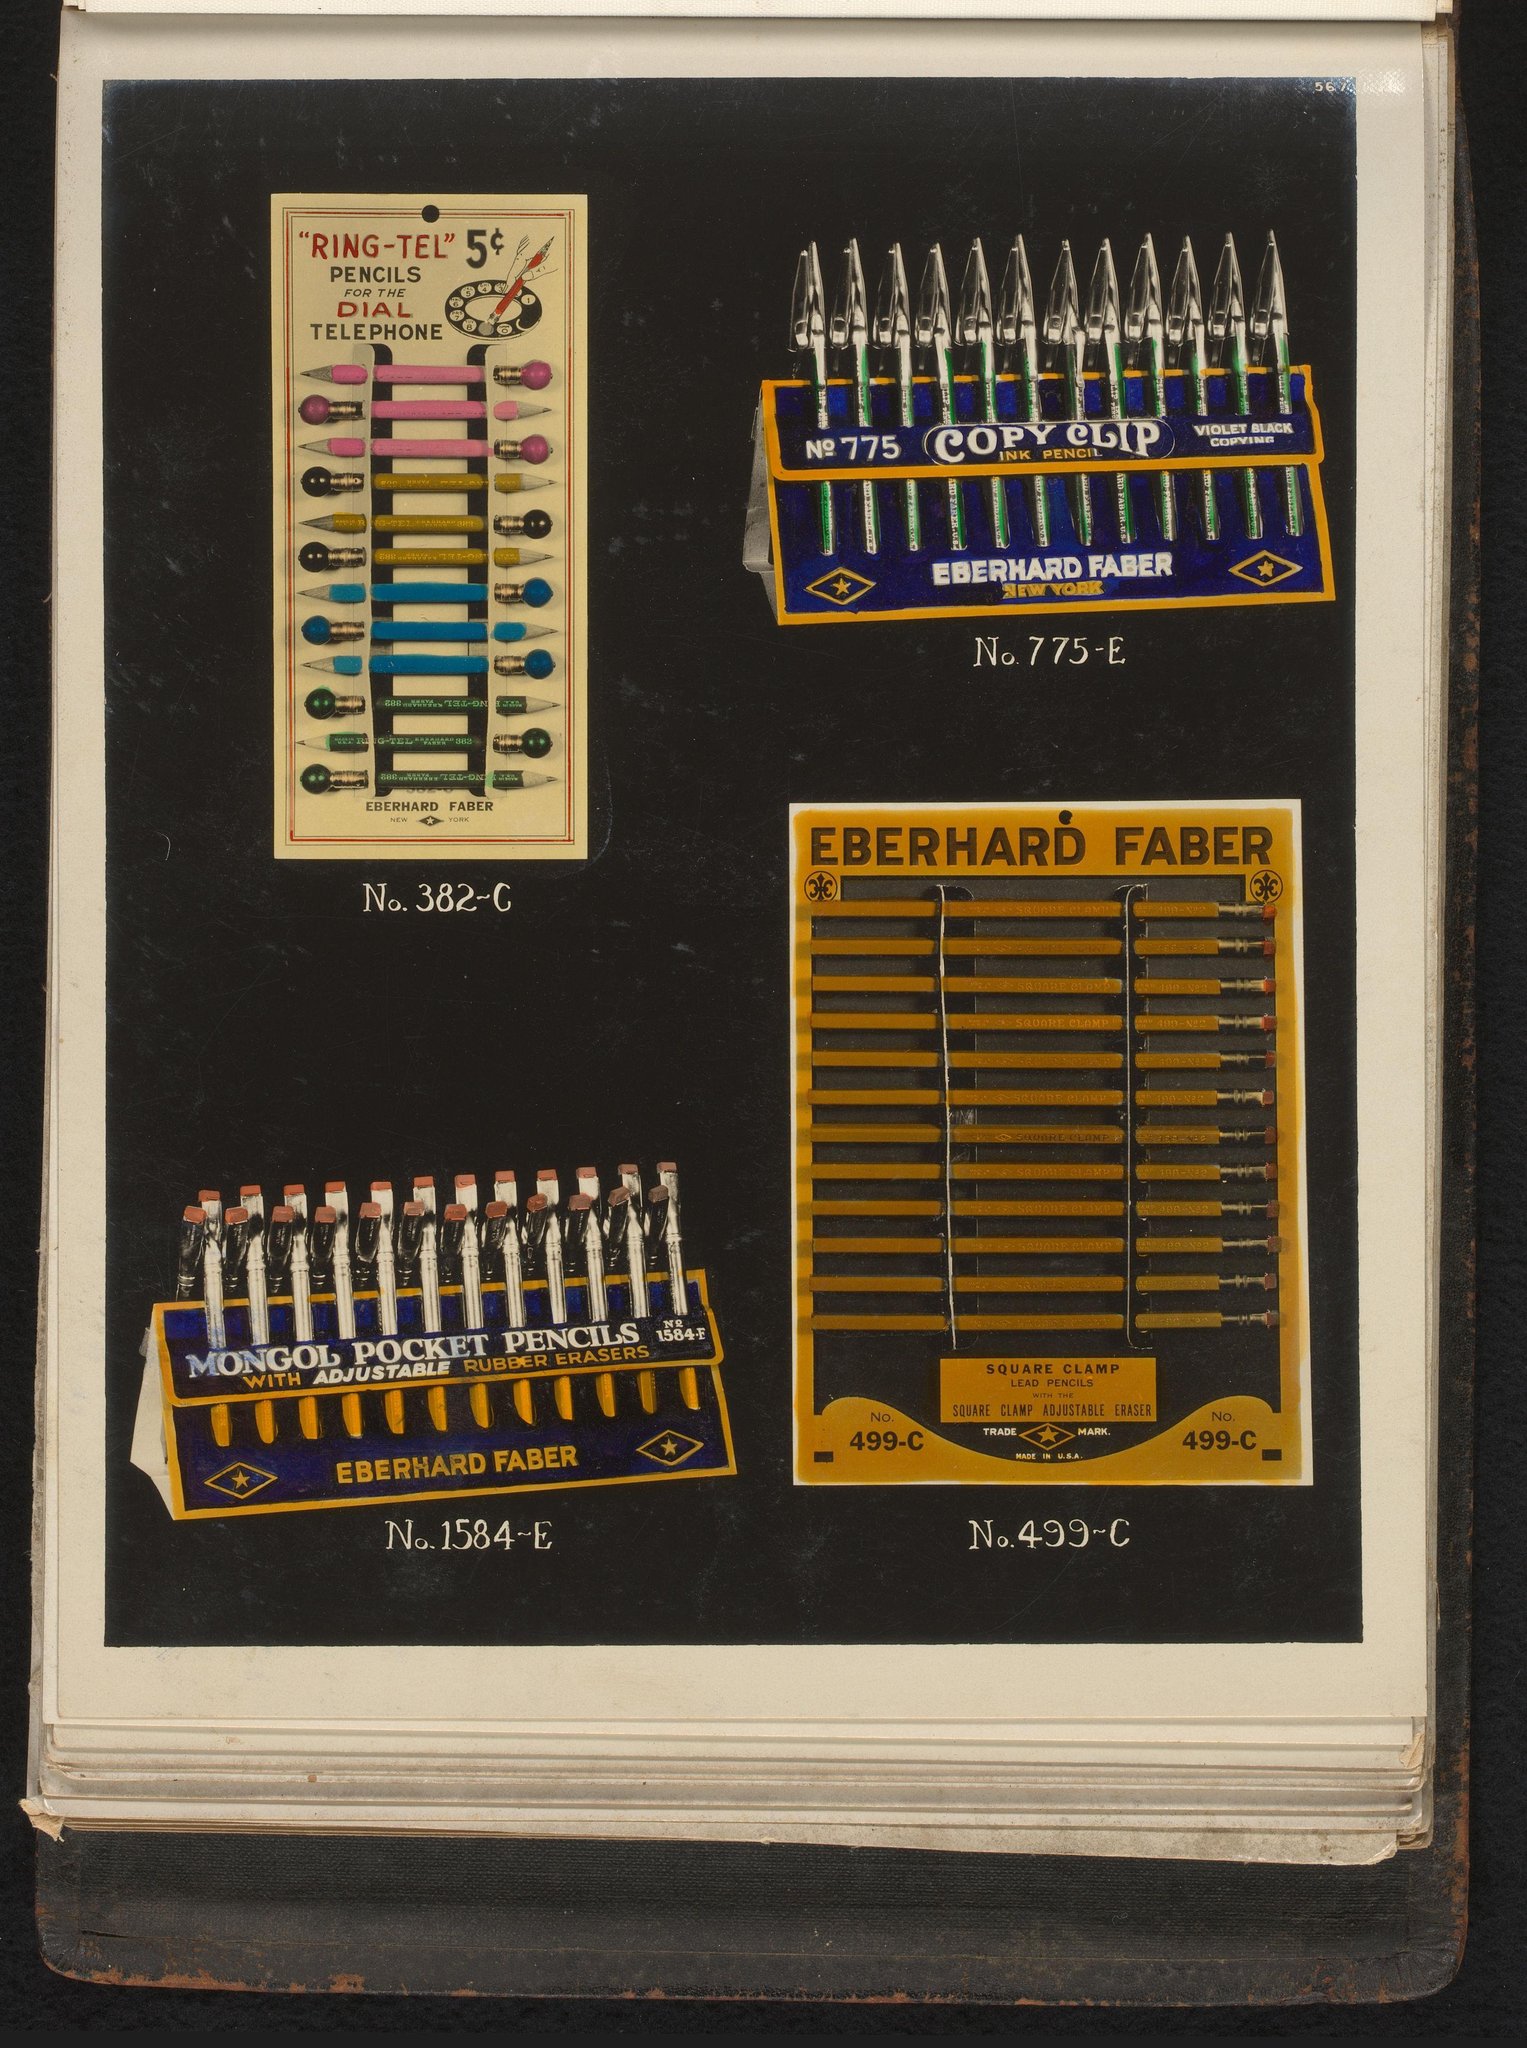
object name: album leaf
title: Standaarden met potloden van Eberhard Faber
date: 1915-1935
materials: paper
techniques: gelatin silver print, hand coloring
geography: springfield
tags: pencil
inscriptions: stamp: ‘Paramount/ Commercial Studios/ 145 Chestnut St./ Springfield - Mass.’, number: ‘567’